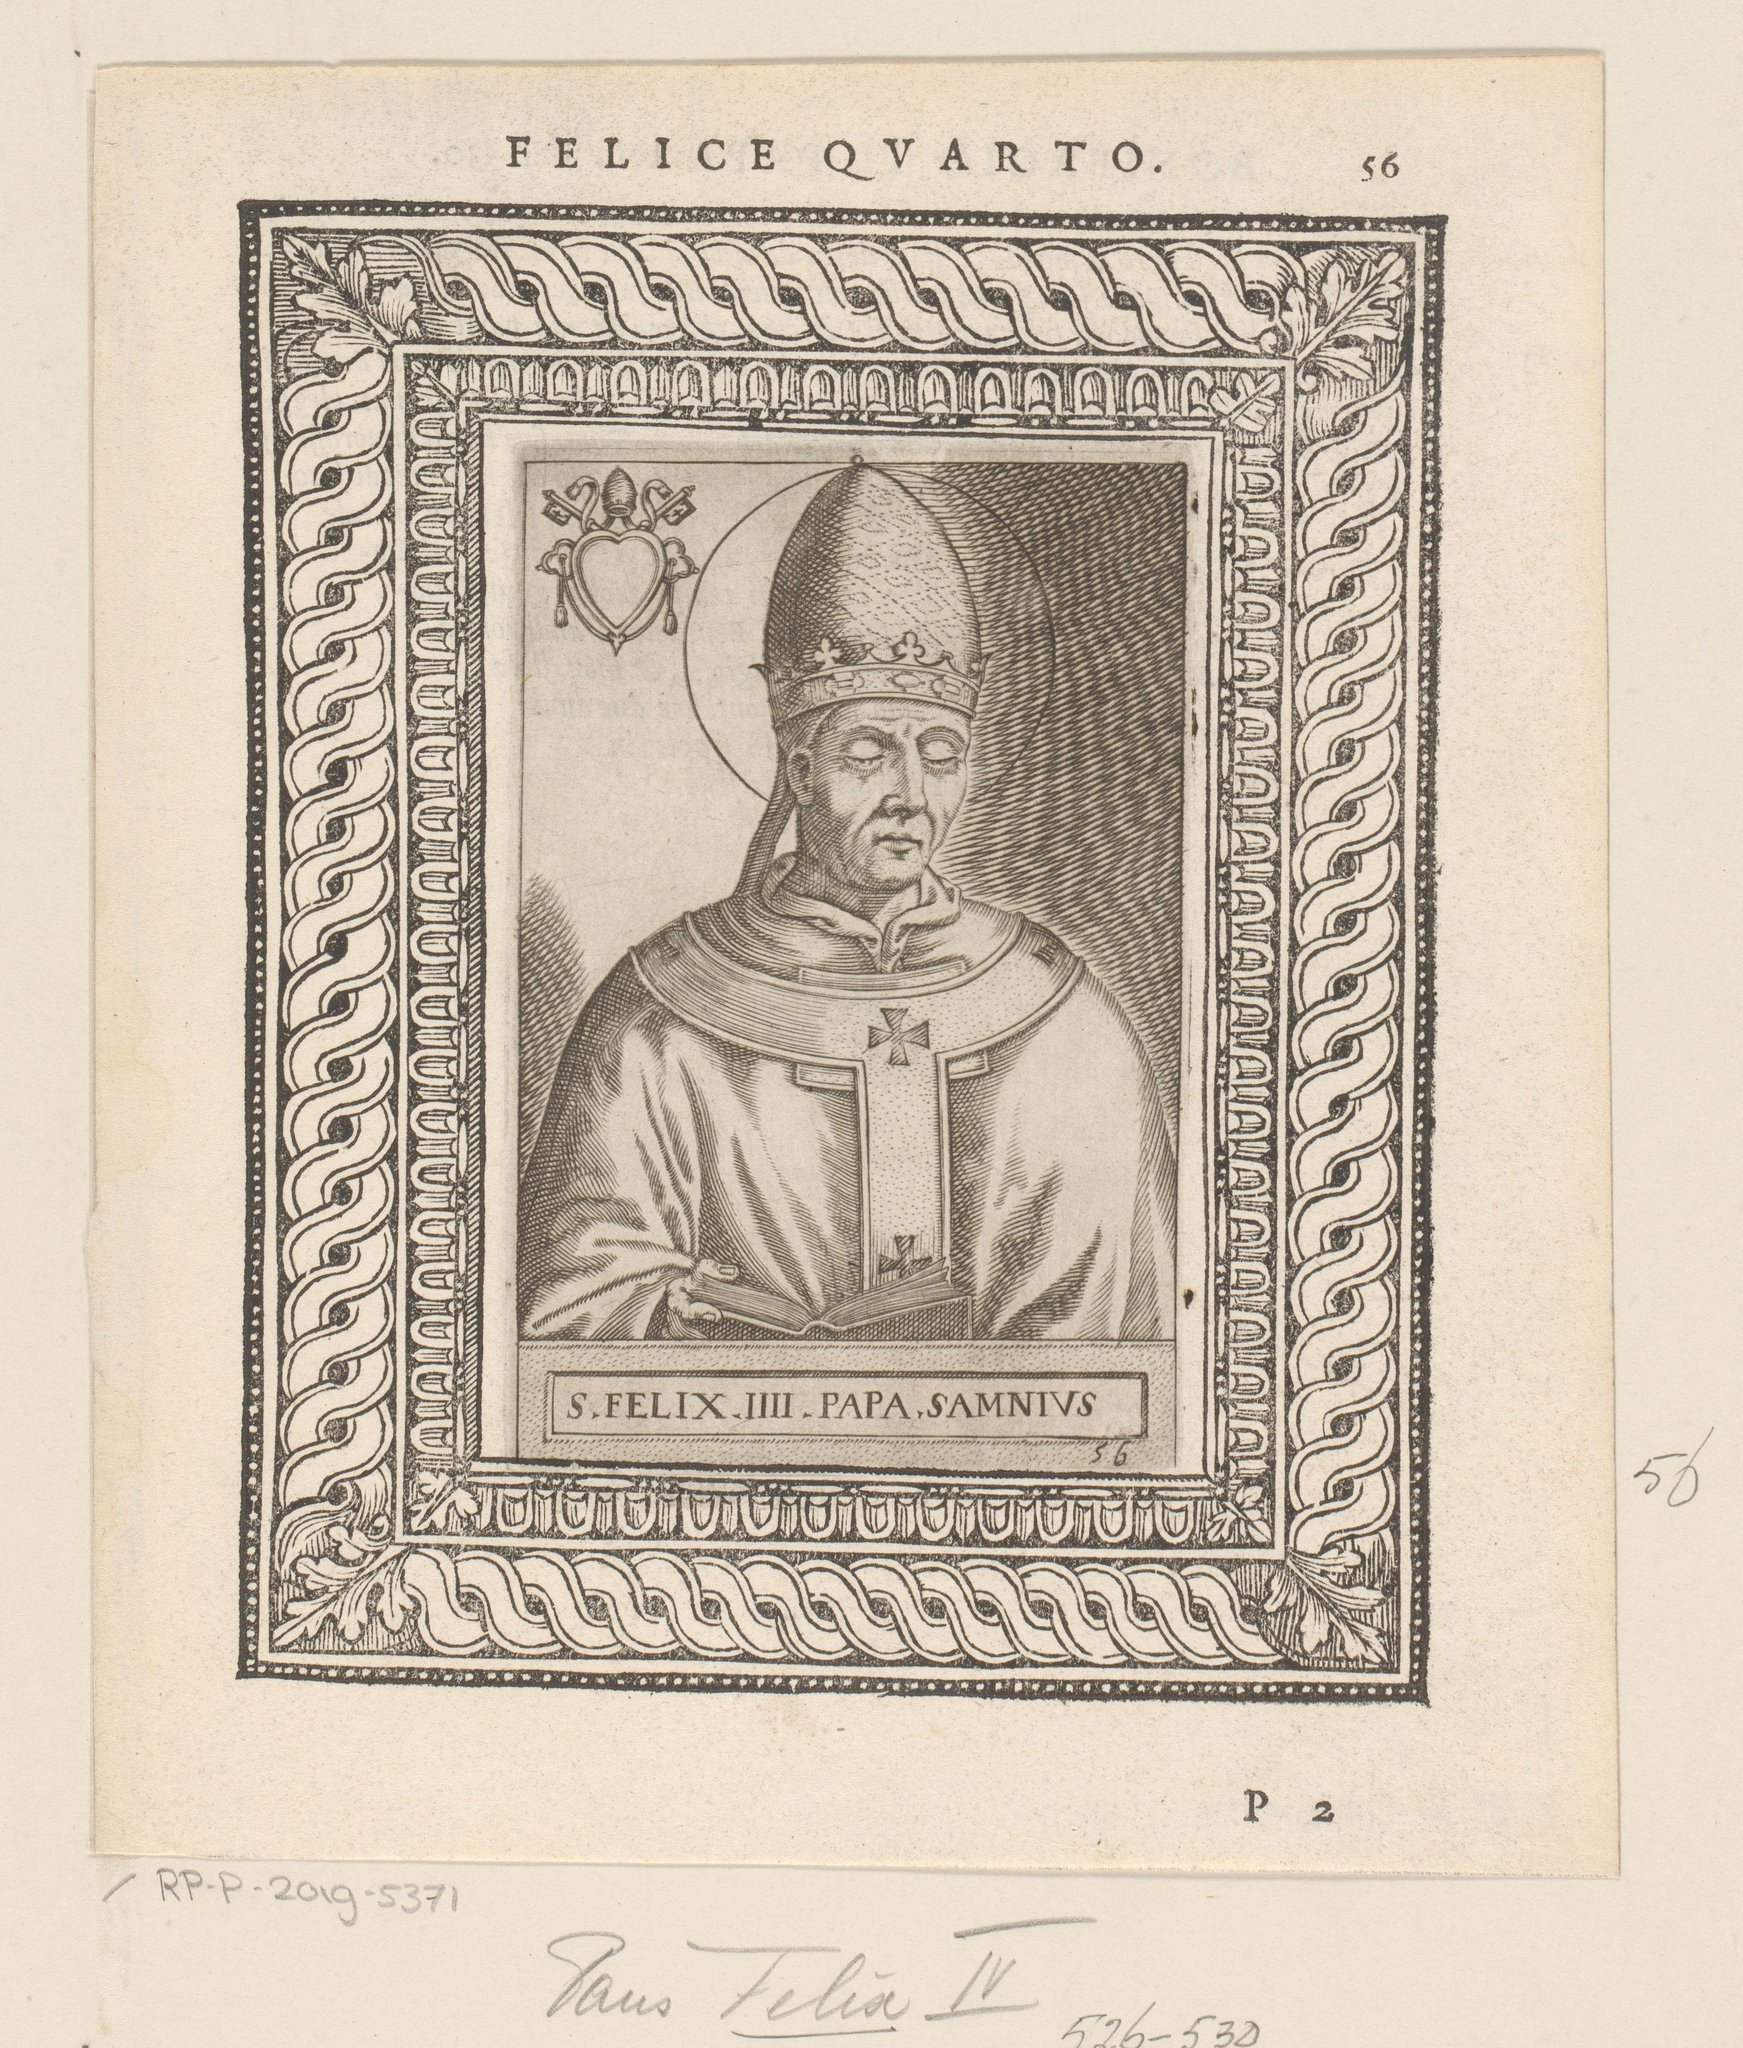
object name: book illustration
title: S. Felix IIII Papa Samnius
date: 1587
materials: paper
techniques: engraving, letterpress printing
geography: rome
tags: historical persons, pope, armorial bearing, heraldry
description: Prent uit: Ciccarelli, Antonio. Le vite de Pontefici di Antonio Ciccarelli (...). Rome: Domenico Basa, 1587. Prent voor het eerst verschenen in: Cavalieri, Giovanni Battista de'. Pontificum romanorum effigies (...). Rome: Domenico Basa en Francesco Zanetti, 1580. Prent ook gebruikt in latere publicaties.